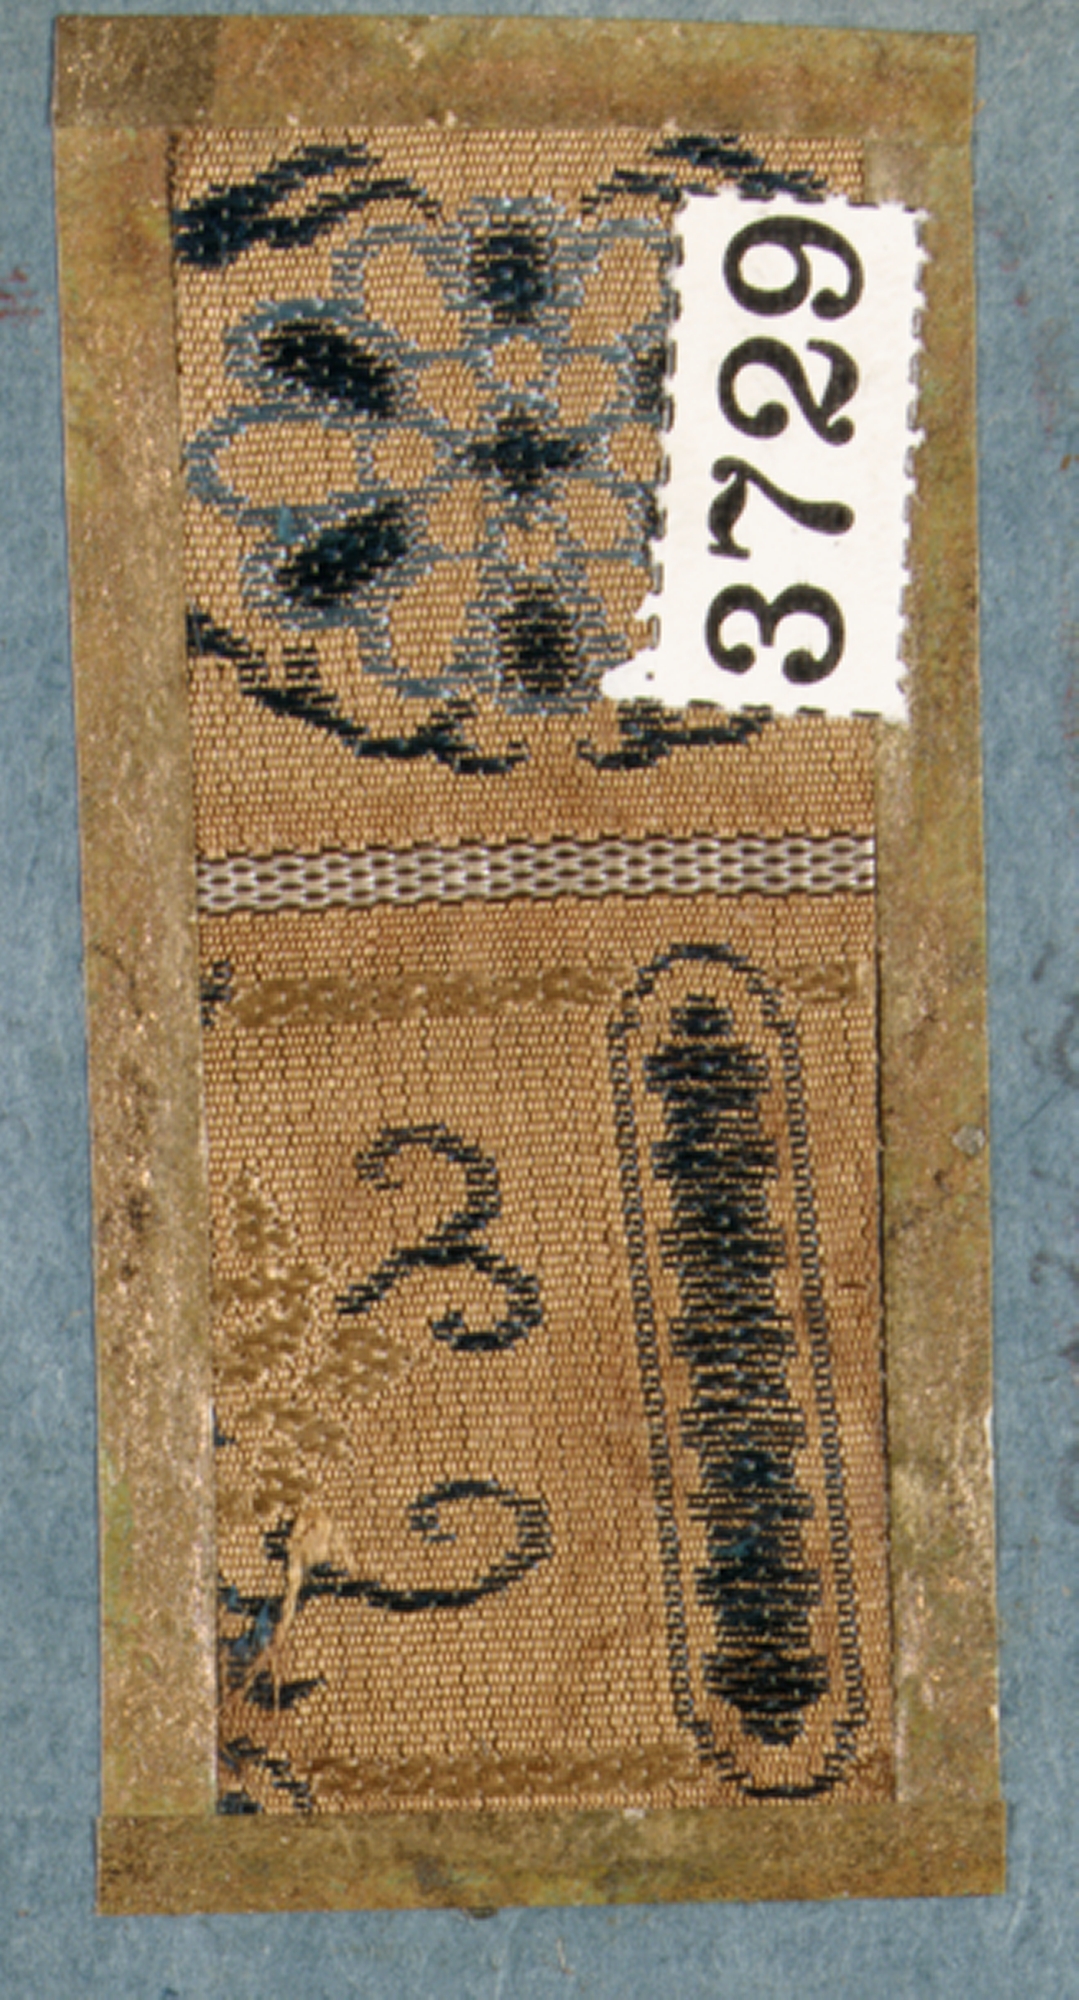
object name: sample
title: Textile Sample from Sample Book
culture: japanese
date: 1801-1900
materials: silk